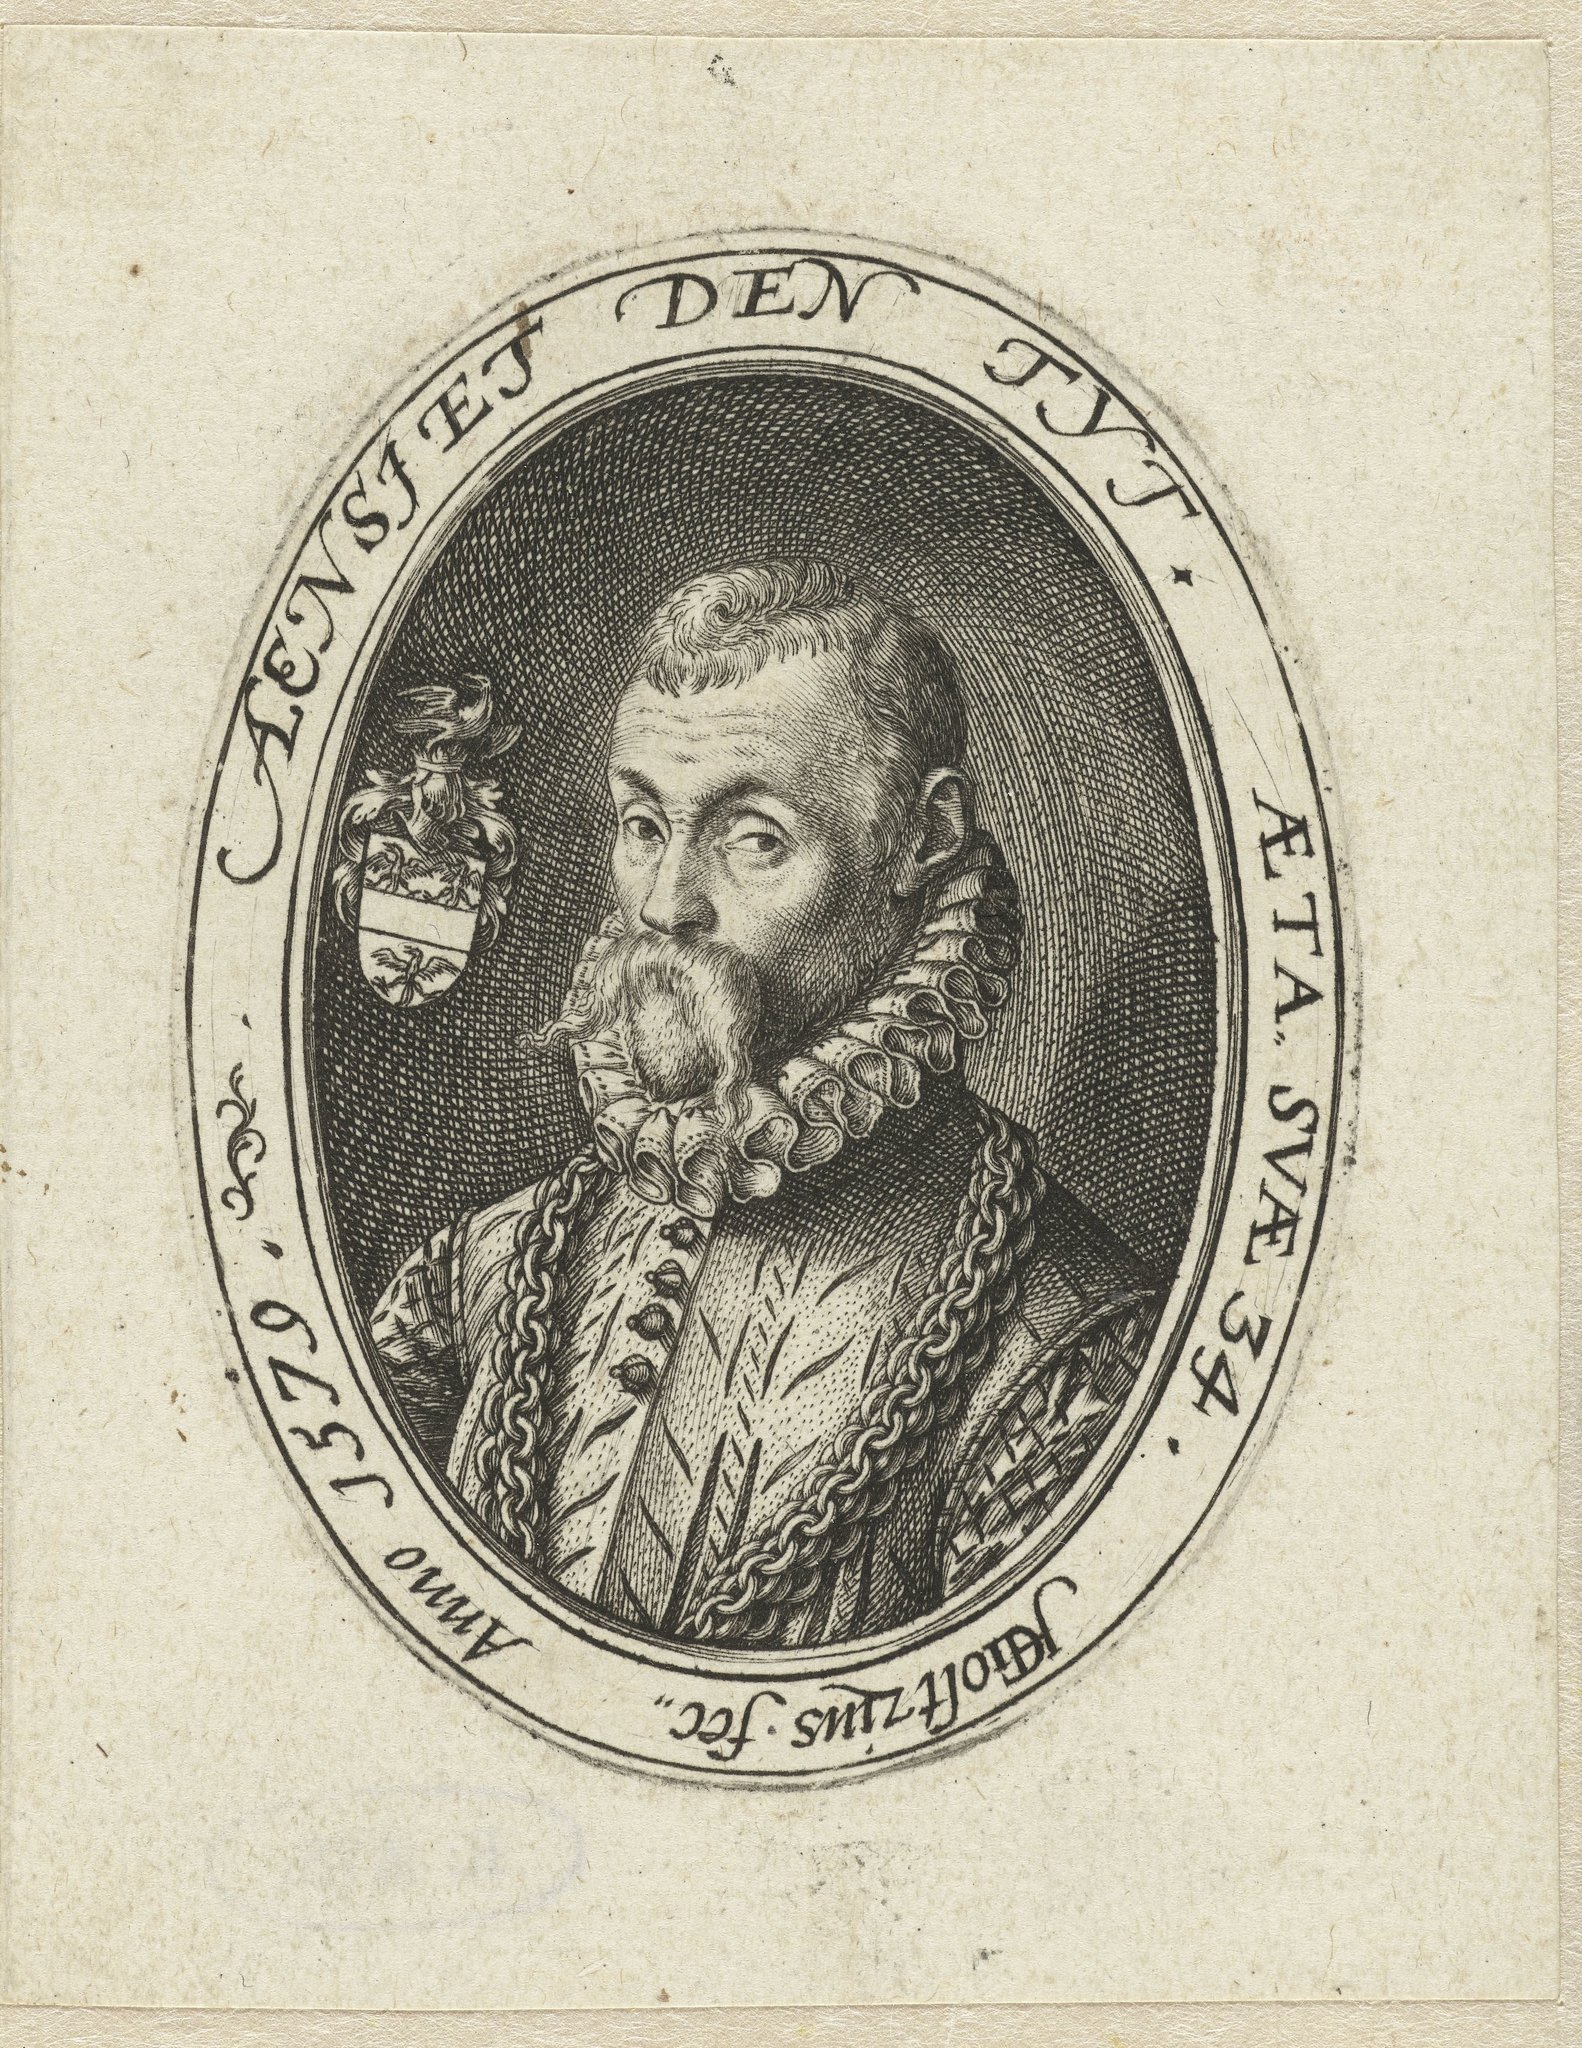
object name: print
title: Aensiet den tyt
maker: hendrick goltzius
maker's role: draughtsman, painter, print maker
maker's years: 1558-1617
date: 1579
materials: paper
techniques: engraving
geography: haarlem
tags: anonymous historical person portrayed alone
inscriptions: signature and date: ‘HGoltzius fec. Anno 1579’, collector's mark: Lugt 2228a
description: Portret van een 34-jarige man, ten halven lijve. Aan zijn rechterzijde een wapenschild. Portret in een ovaal met randinscriptie in Latijn en Nederlands. Het zou kunnen gaan om Gerrit van Poelgeest of om Claes Lubbertsz. van der Weyde, burgemeester van Haarlem.